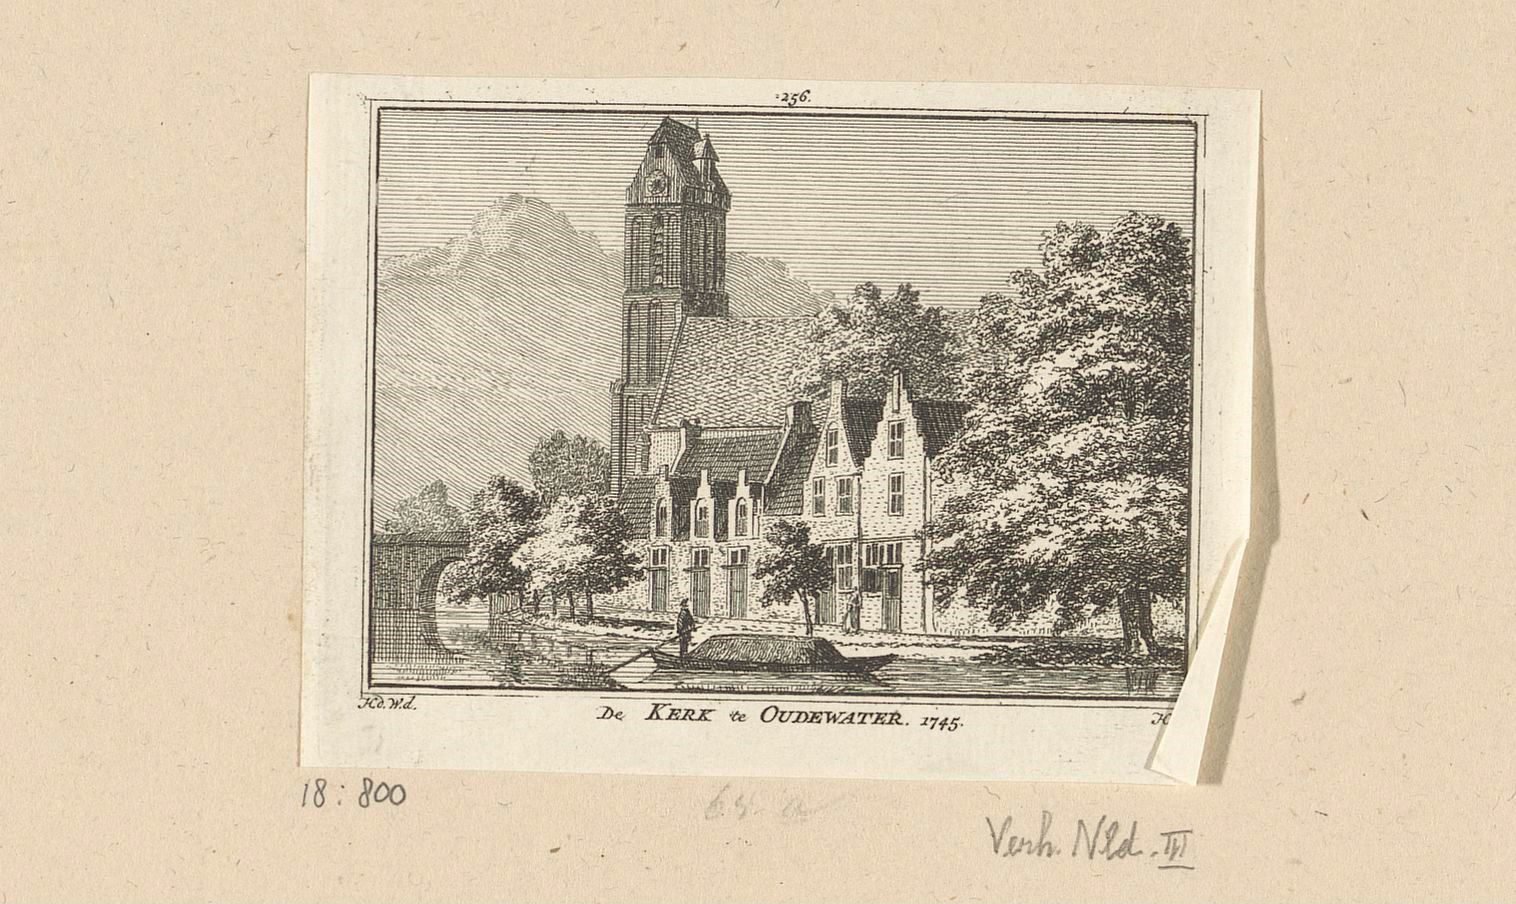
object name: print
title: De kerk te Oudewater. 1745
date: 1750-1792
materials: paper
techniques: engraving, etching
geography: haarlem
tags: church (exterior), prospect of city, town panorama, silhouette of city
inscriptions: collector's mark: Lugt 2228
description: Prent ook gebruikt in: Het verheerlykt Nederland of kabinet van hedendaagsche gezigten van steden, dorpen (…). 9 delen. Amsterdam: Isaak Tirion en weduwe Isaak Tirion, 1745-1774, dl. 3 (1750), ill. 256. Of in: Nederlandsche tafereelen; of eene keurige verzameling van negen honderd fraaije gezigten van steden, dorpen, sloten, oudheden (….). 9 delen. Amsterdam: Jan de Groot, 1792, dl. 3, ill. 256. Zie RP-T-1888-A-1827 voor de tekening waar deze prent op is gebaseerd.